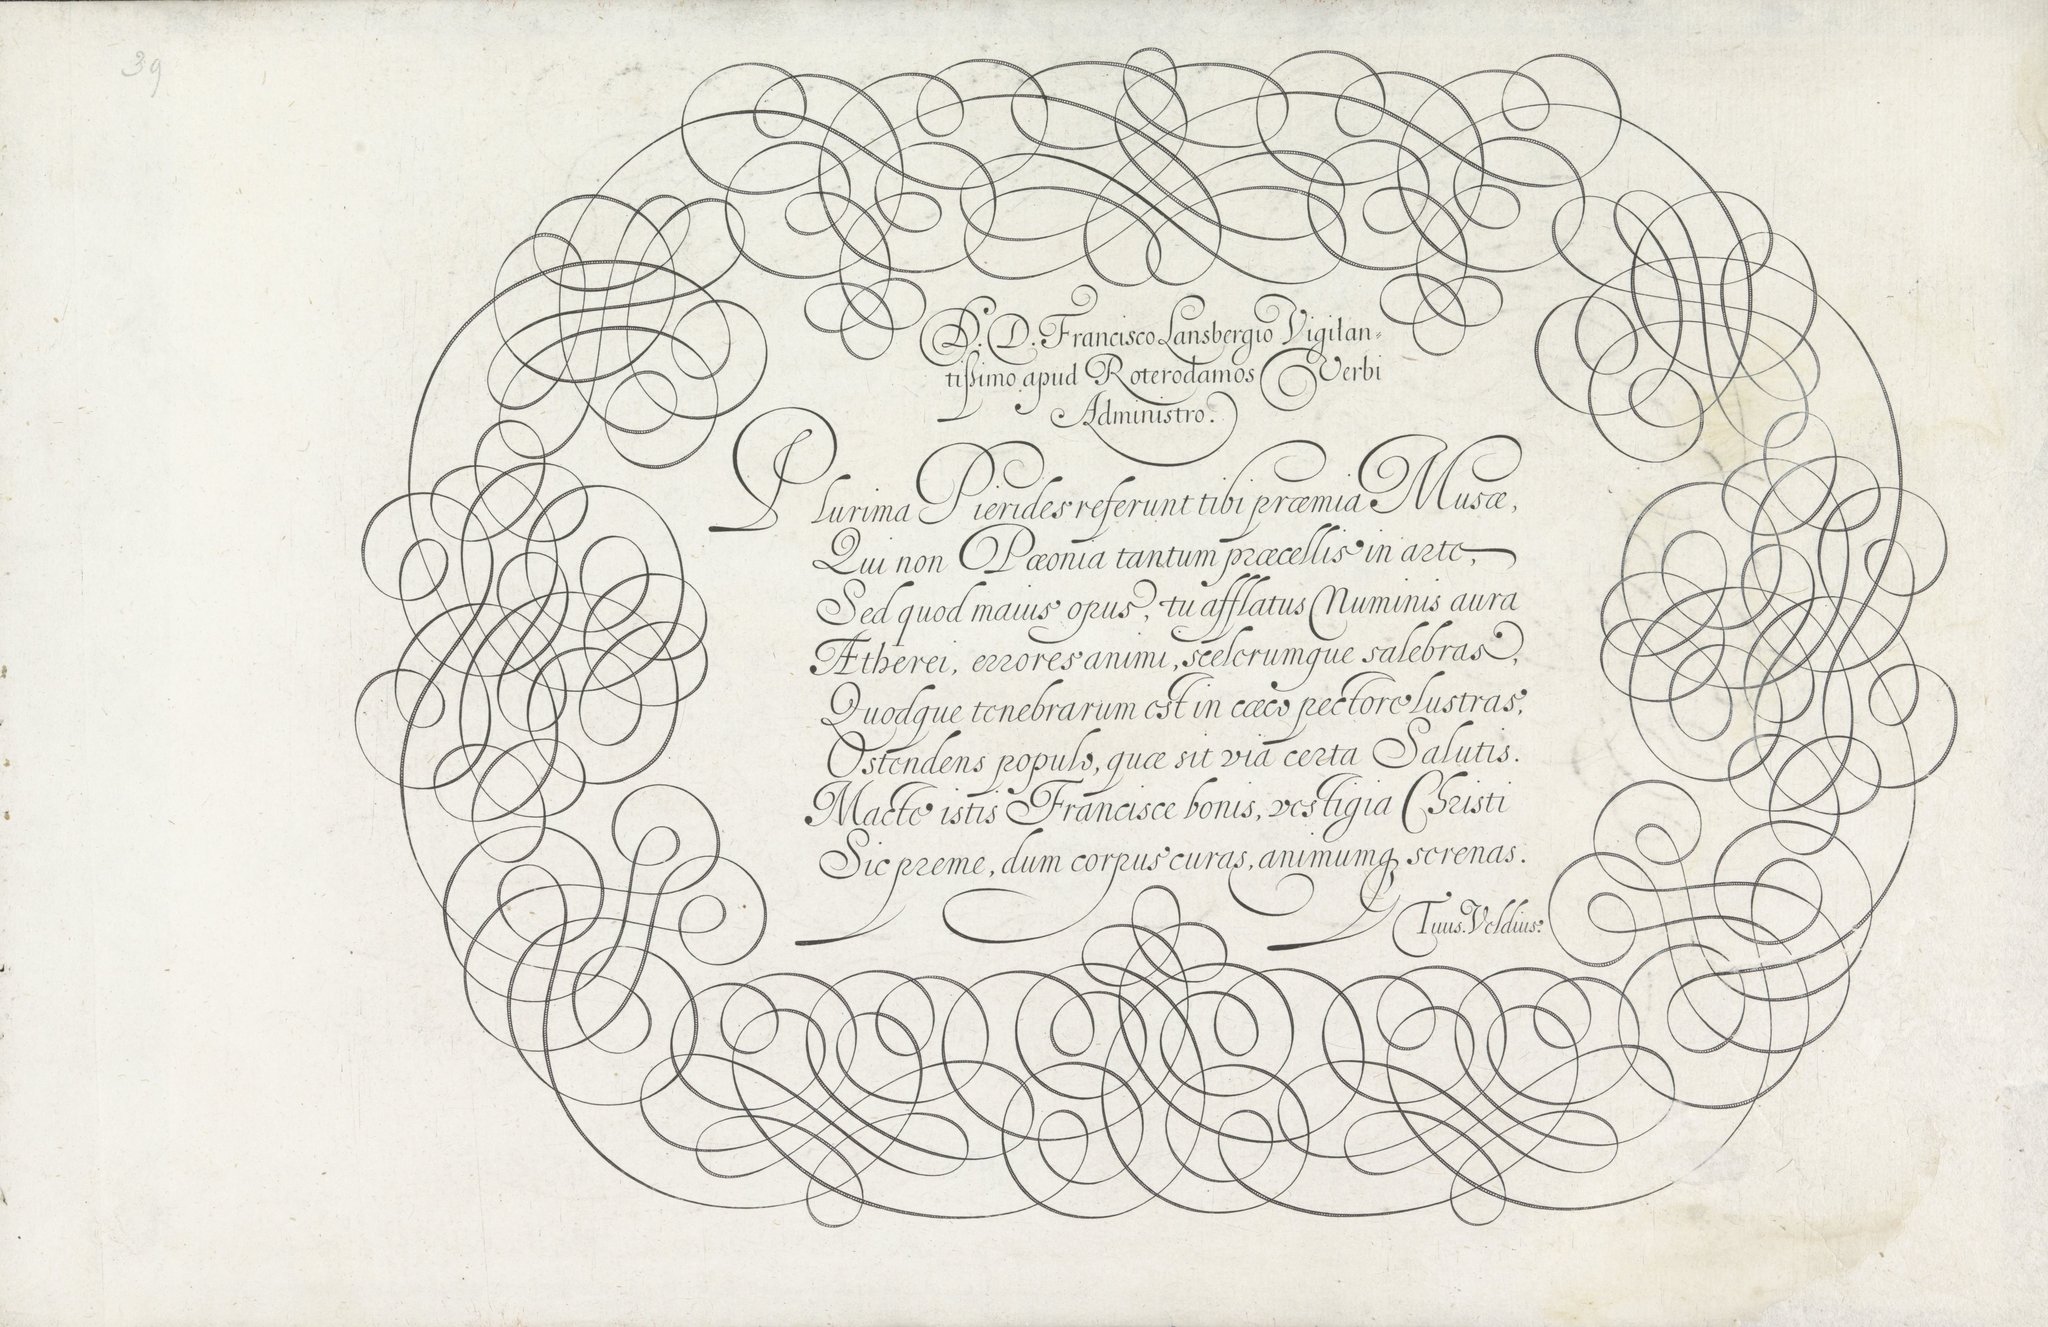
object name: print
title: Spieghel der schrijfkonste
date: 1605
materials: paper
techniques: engraving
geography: haarlem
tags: calligraphy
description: Schrijfvoorbeeld met de aanhef: D.D. Francisco Lansbergio vigilantissimo apud Roterodamos verbi administro. Daaronder acht regels tekst in het Latijn: Plurima pieridus referunt ... Ondertekend: Tuus Veldius. De tekst is omlijst door krulwerk. De prent maakt deel uit van een album.